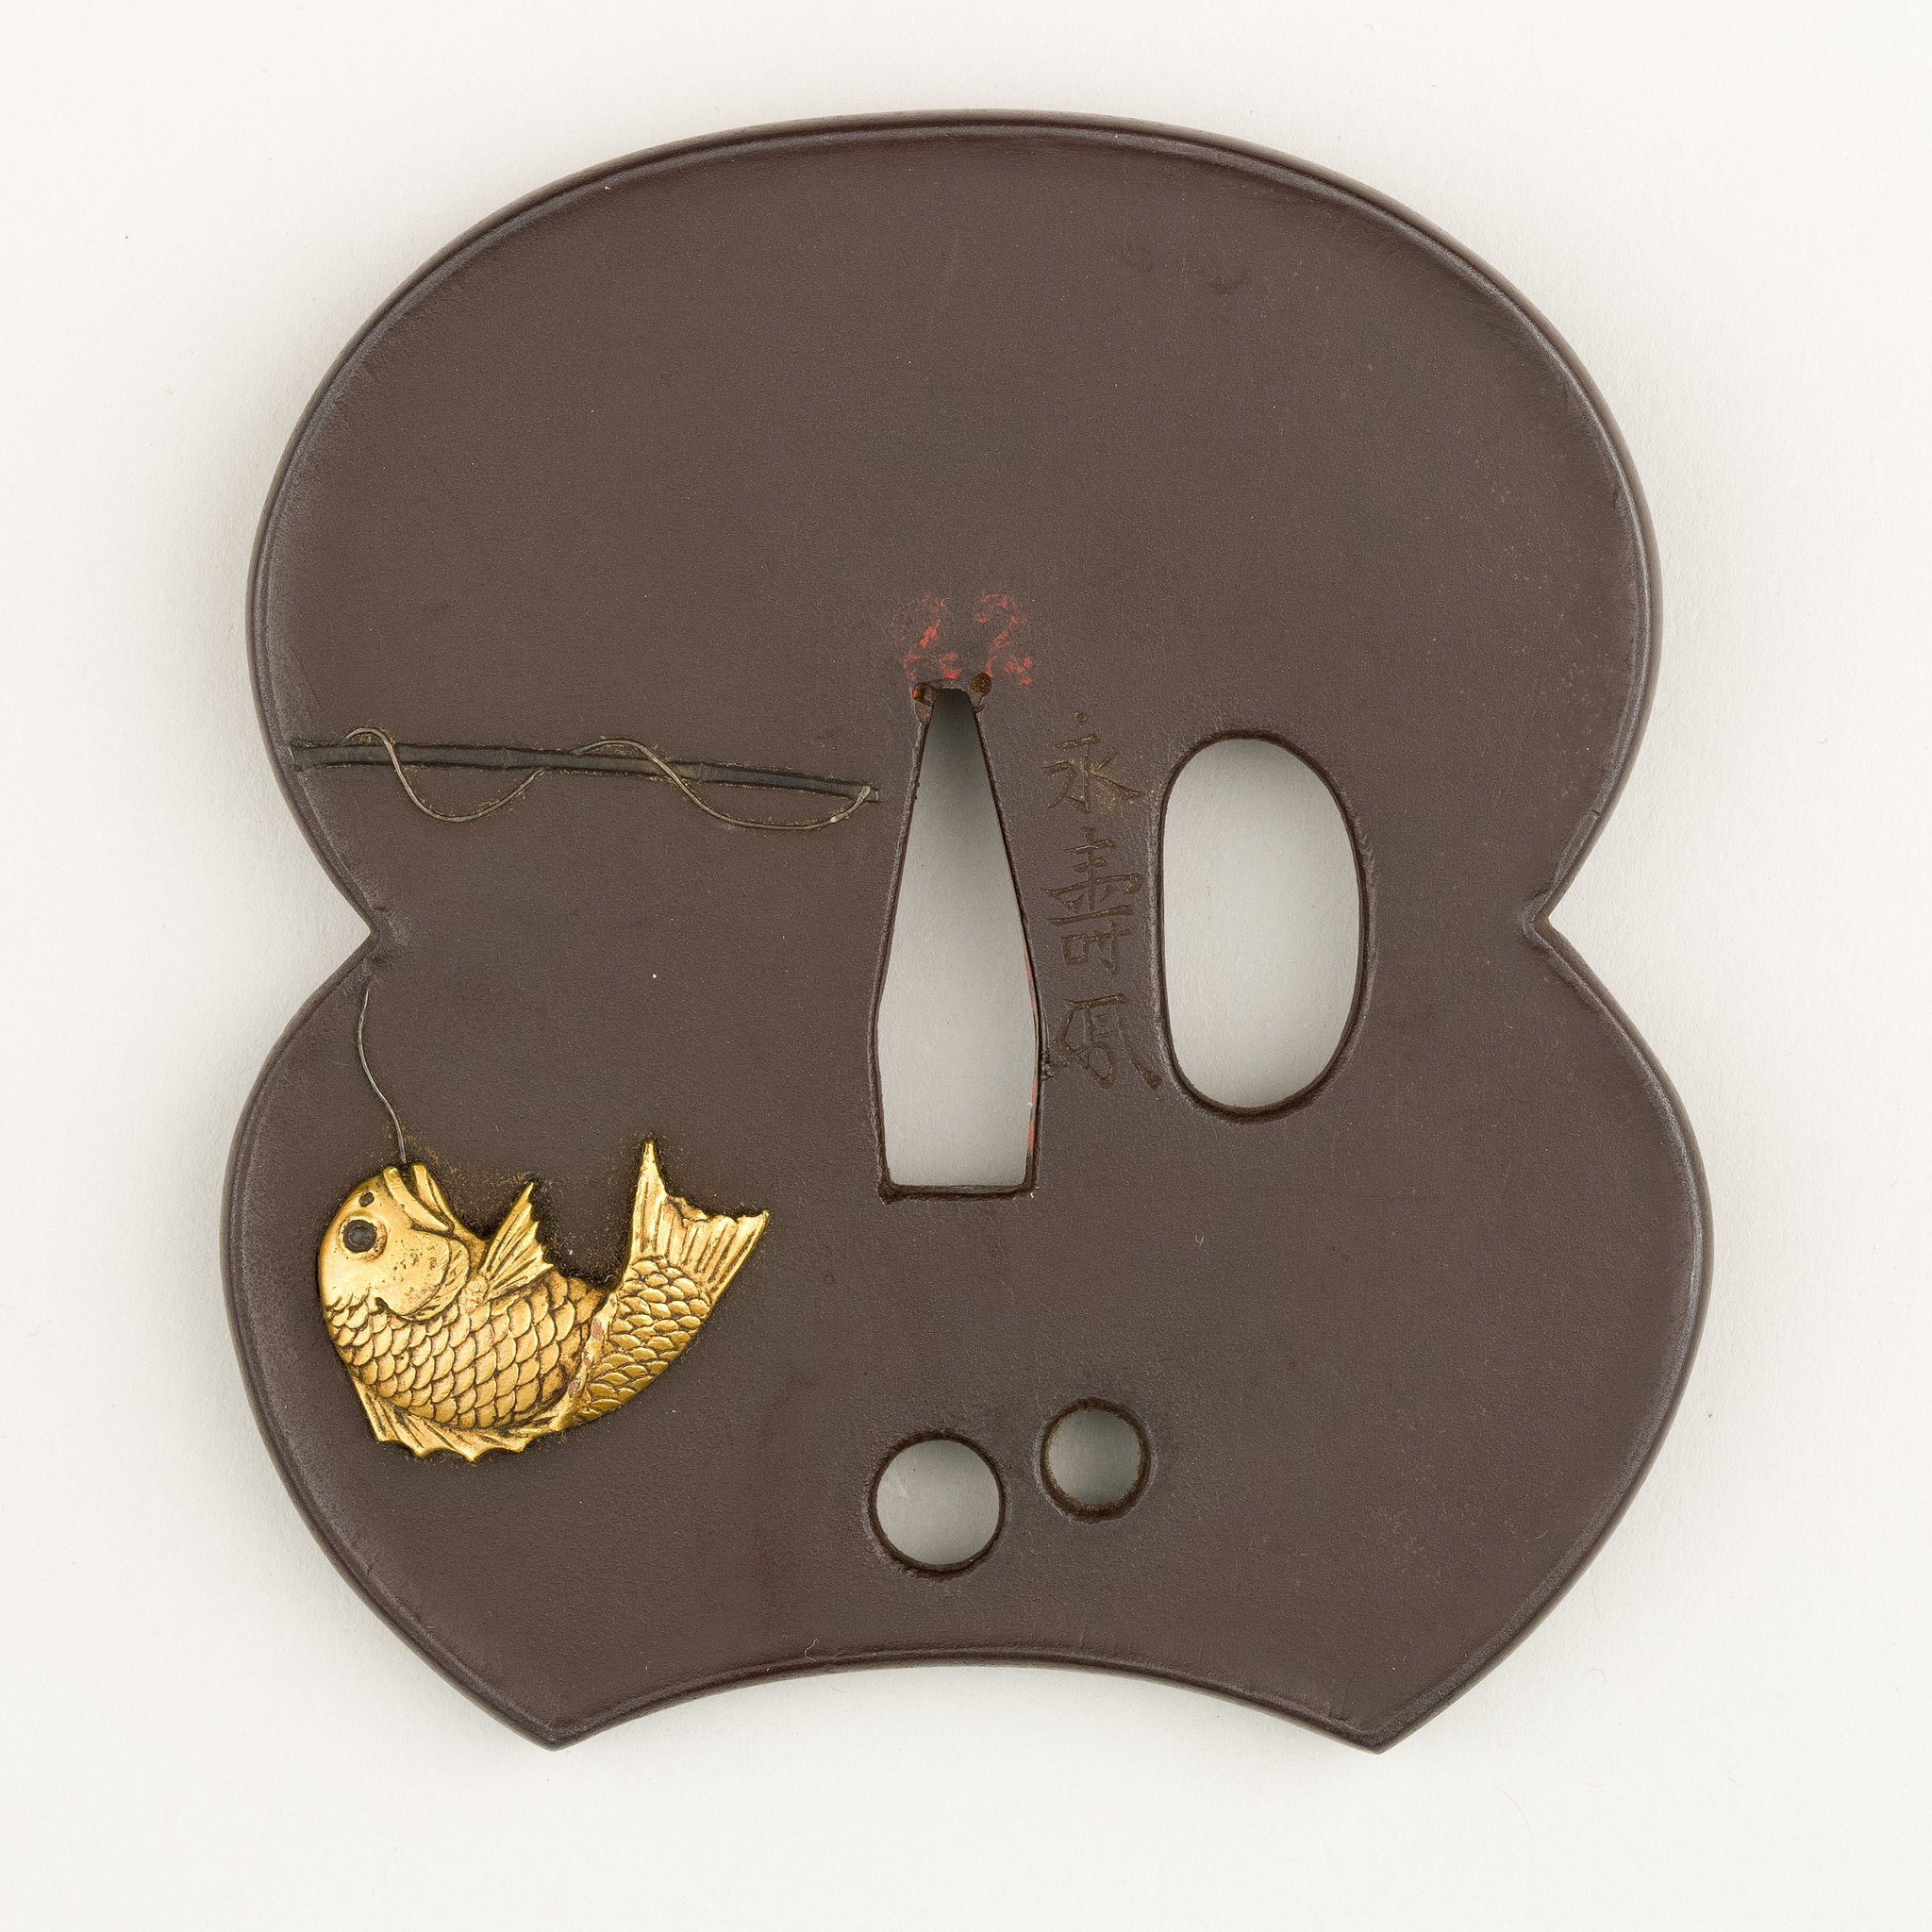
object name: sword guard tsuba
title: Sword Guard (Tsuba)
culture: japanese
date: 1801-1900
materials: gold, iron, silver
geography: japan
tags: men,fish